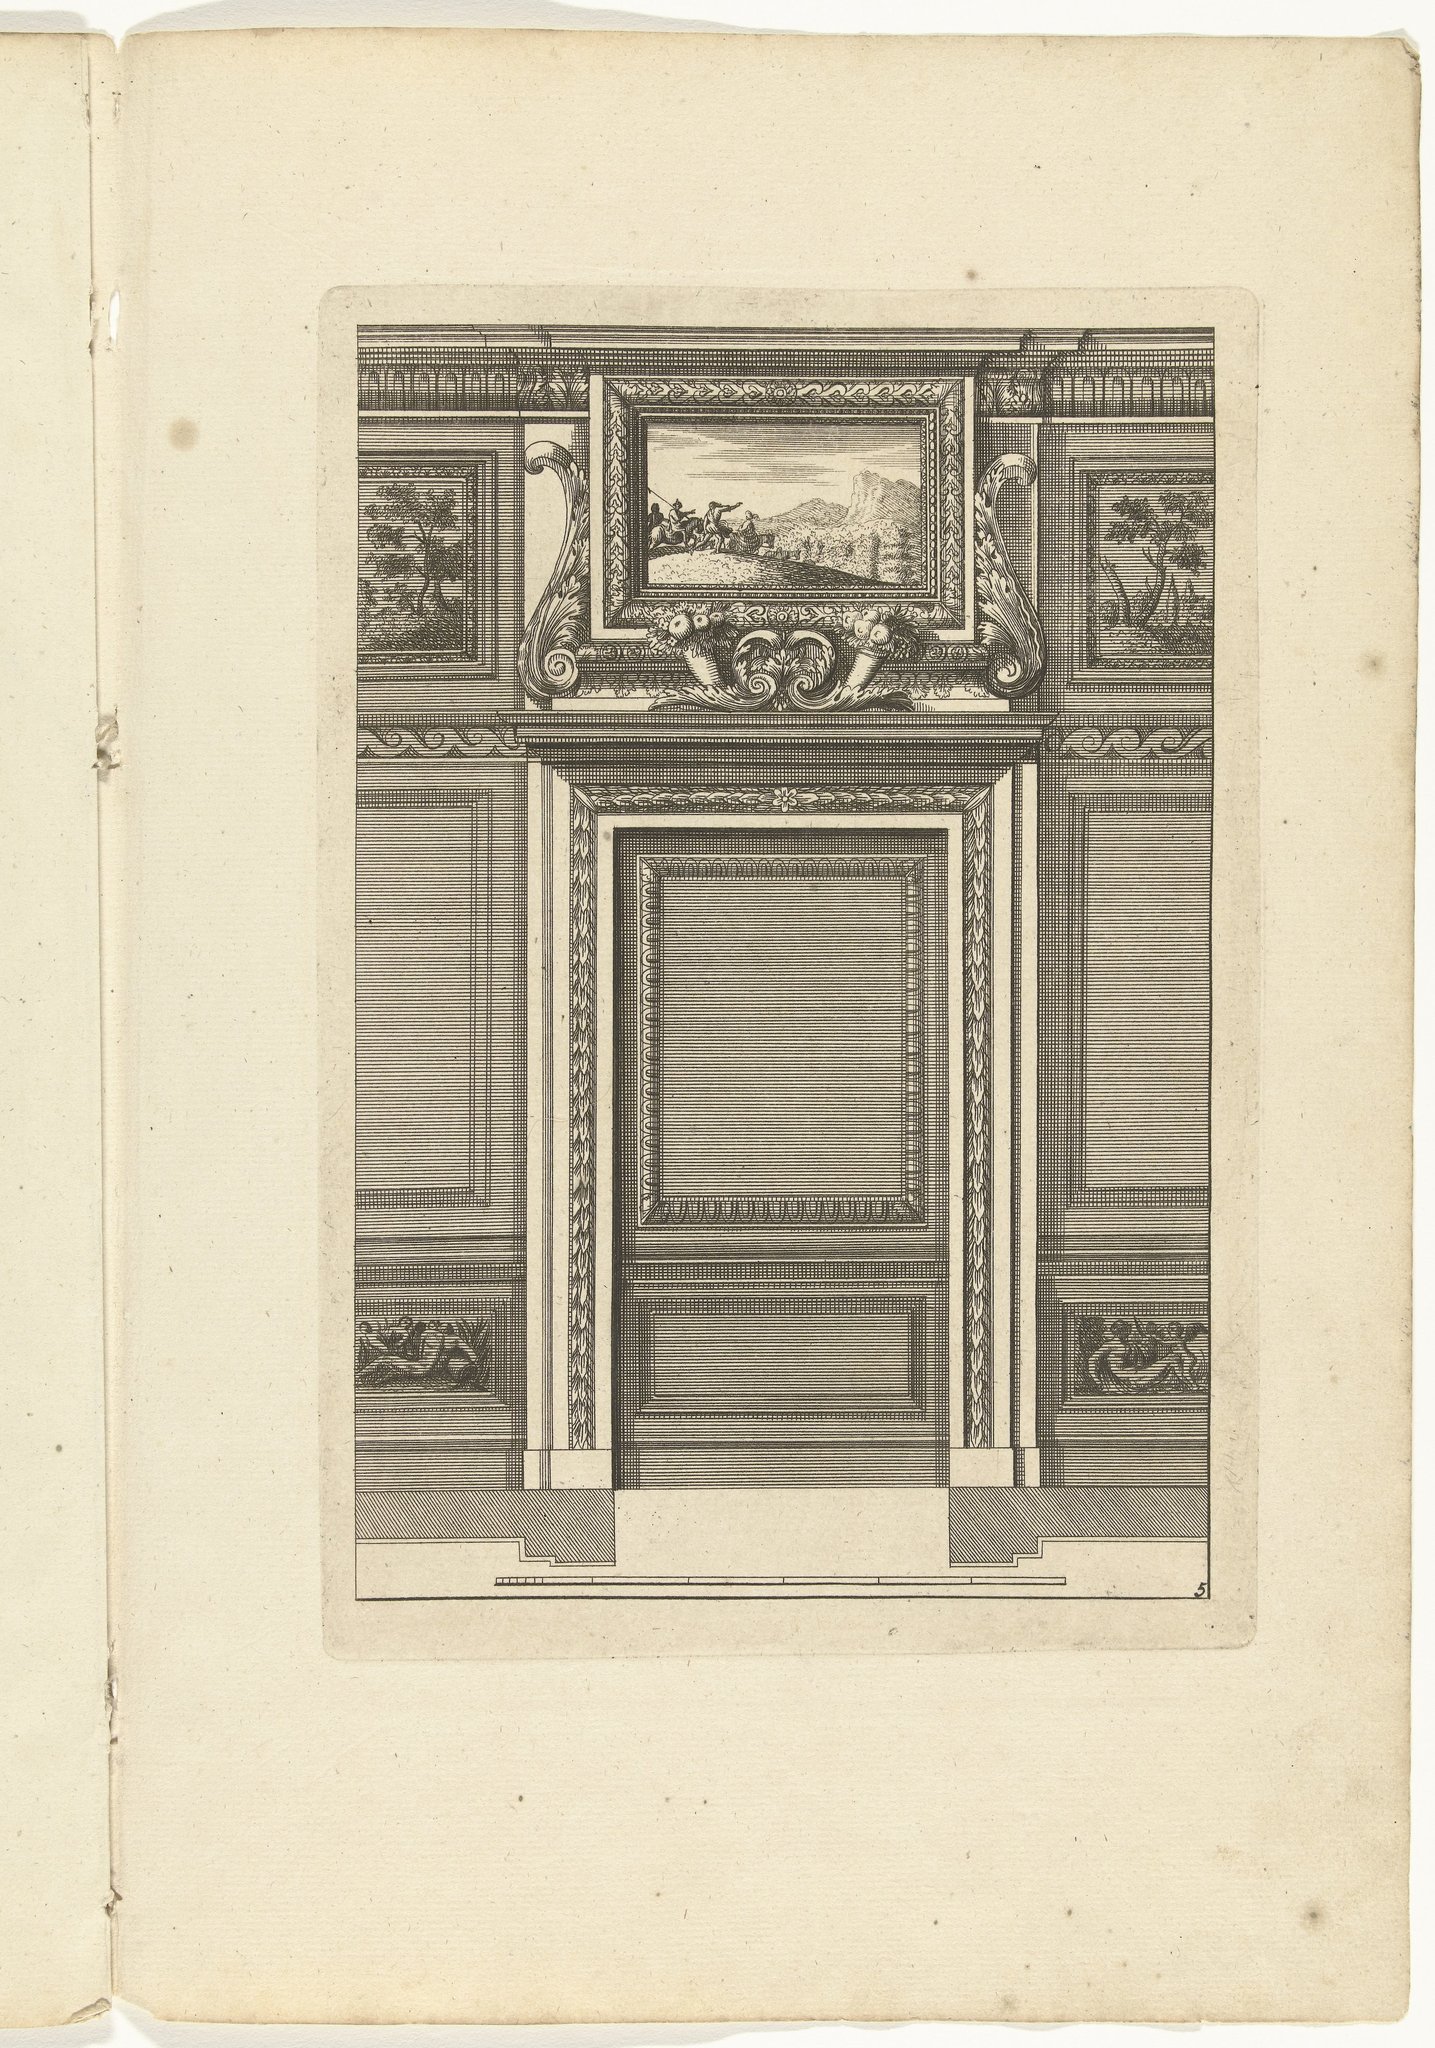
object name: print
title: Deur met lege omlijsting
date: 1726-1750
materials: paper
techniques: etching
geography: amsterdam